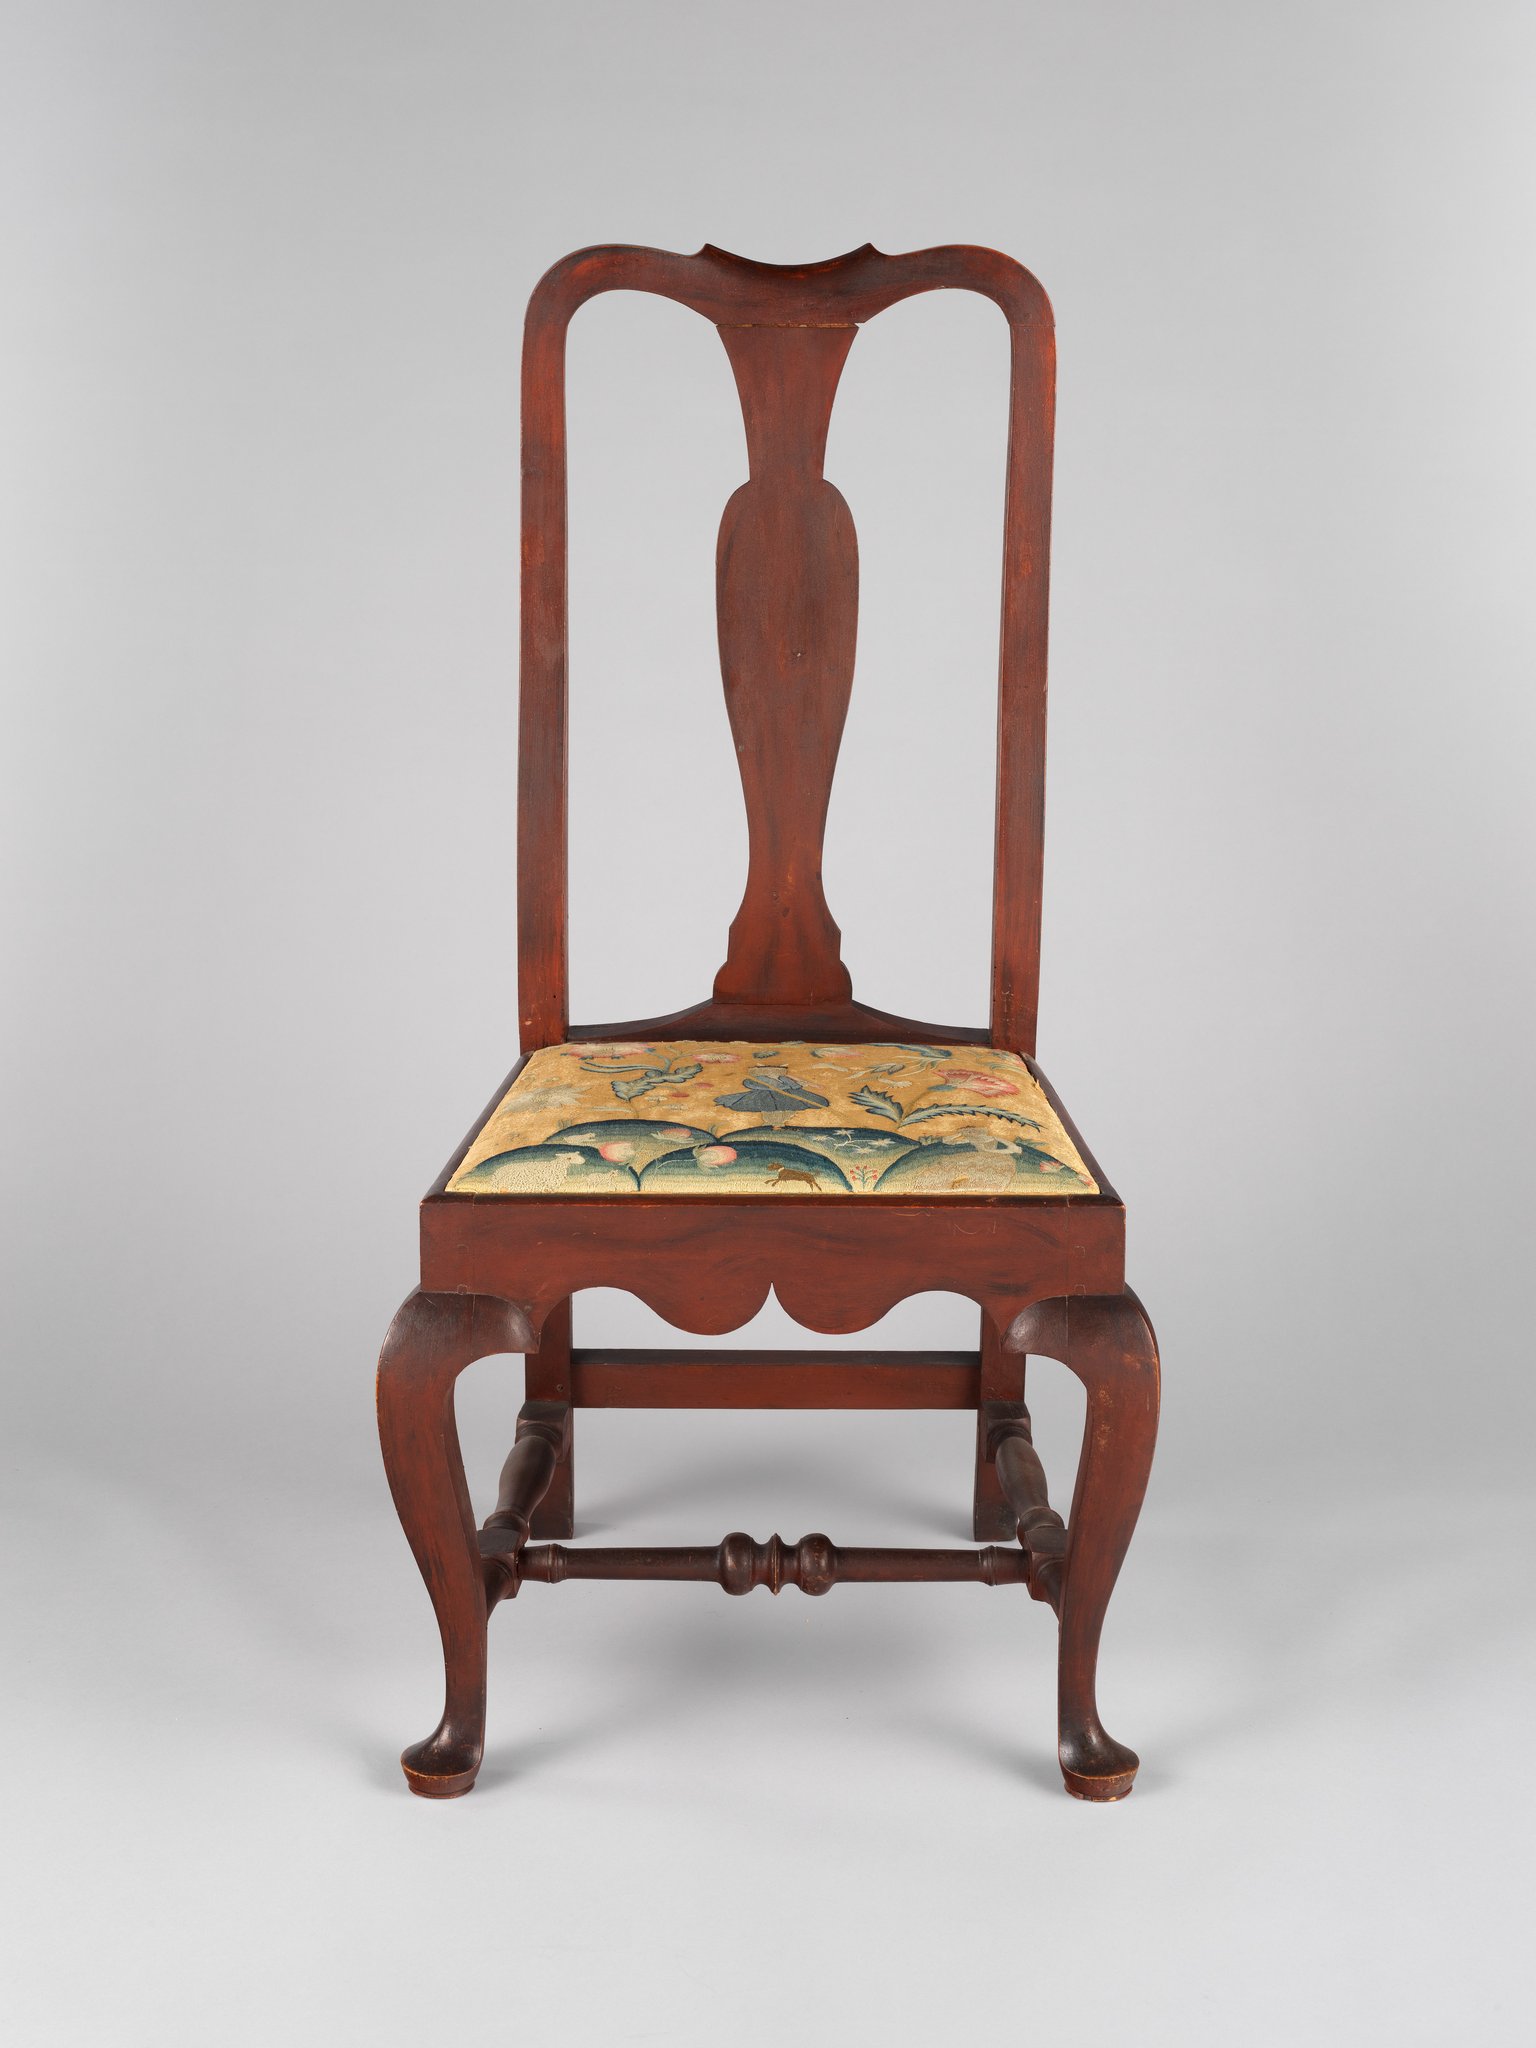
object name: side chair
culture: american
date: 1735-1760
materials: linen, wood, wool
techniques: painting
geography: united states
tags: birds,men